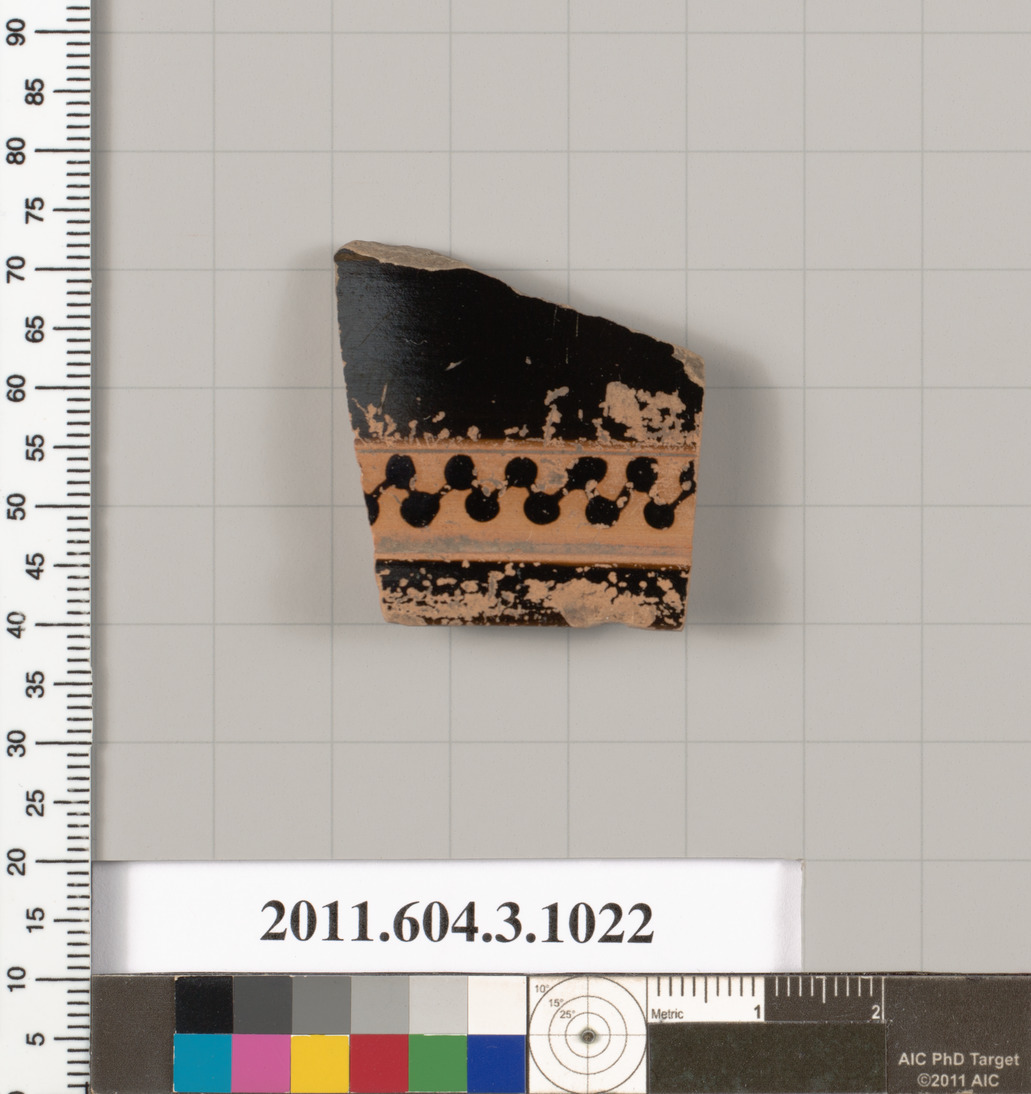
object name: lekanis fragment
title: Terracotta fragment of a lekanis (covered dish)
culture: greek, attic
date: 475-451 BCE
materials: terracotta